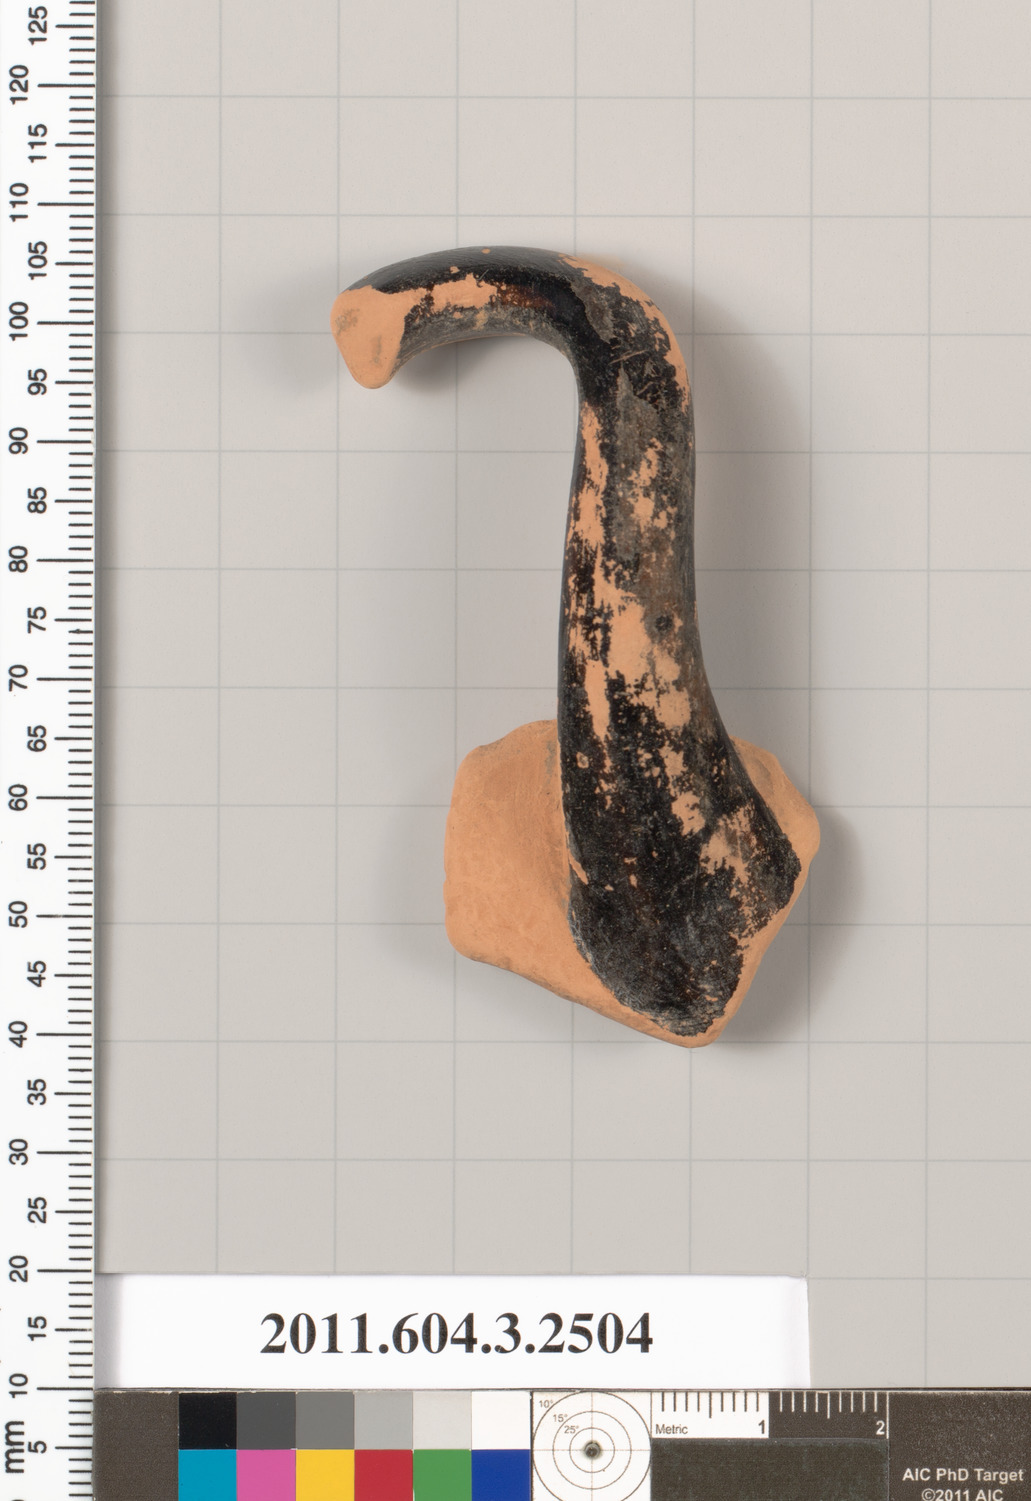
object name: kylix fragment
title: Terracotta fragment of a kylix (drinking cup)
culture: greek, attic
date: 600-401 BCE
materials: terracotta